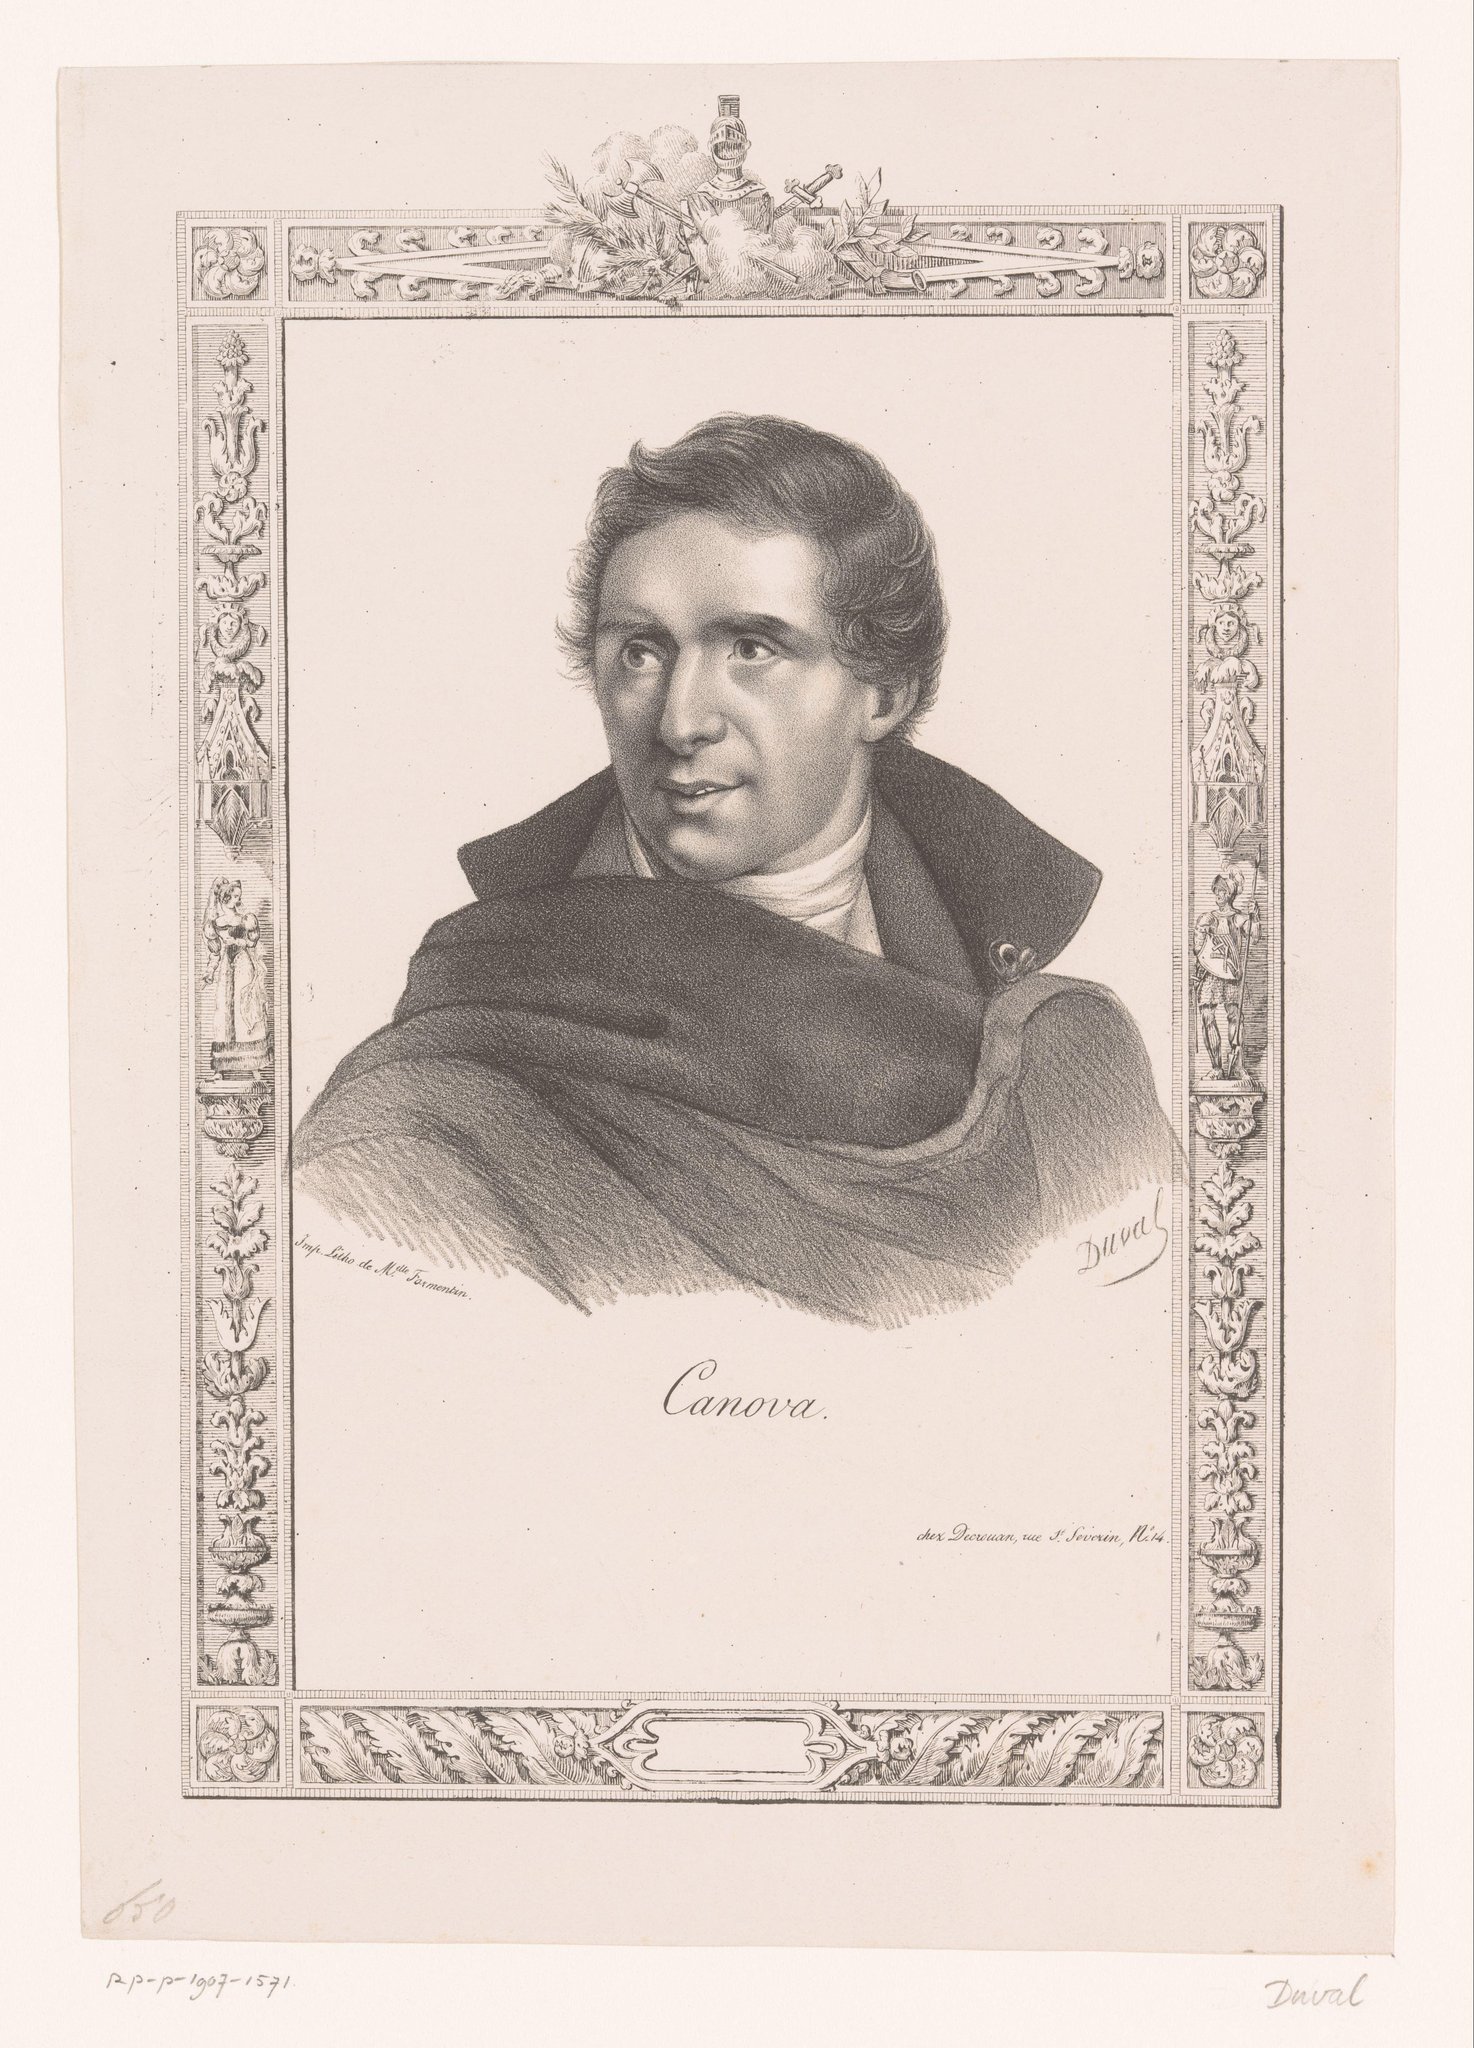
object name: print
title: Canova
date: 1826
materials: paper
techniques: lithograph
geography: paris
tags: venice, painter, draughtsman, sculptor, antonio canova, historical persons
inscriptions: collector's mark: Lugt 2228a